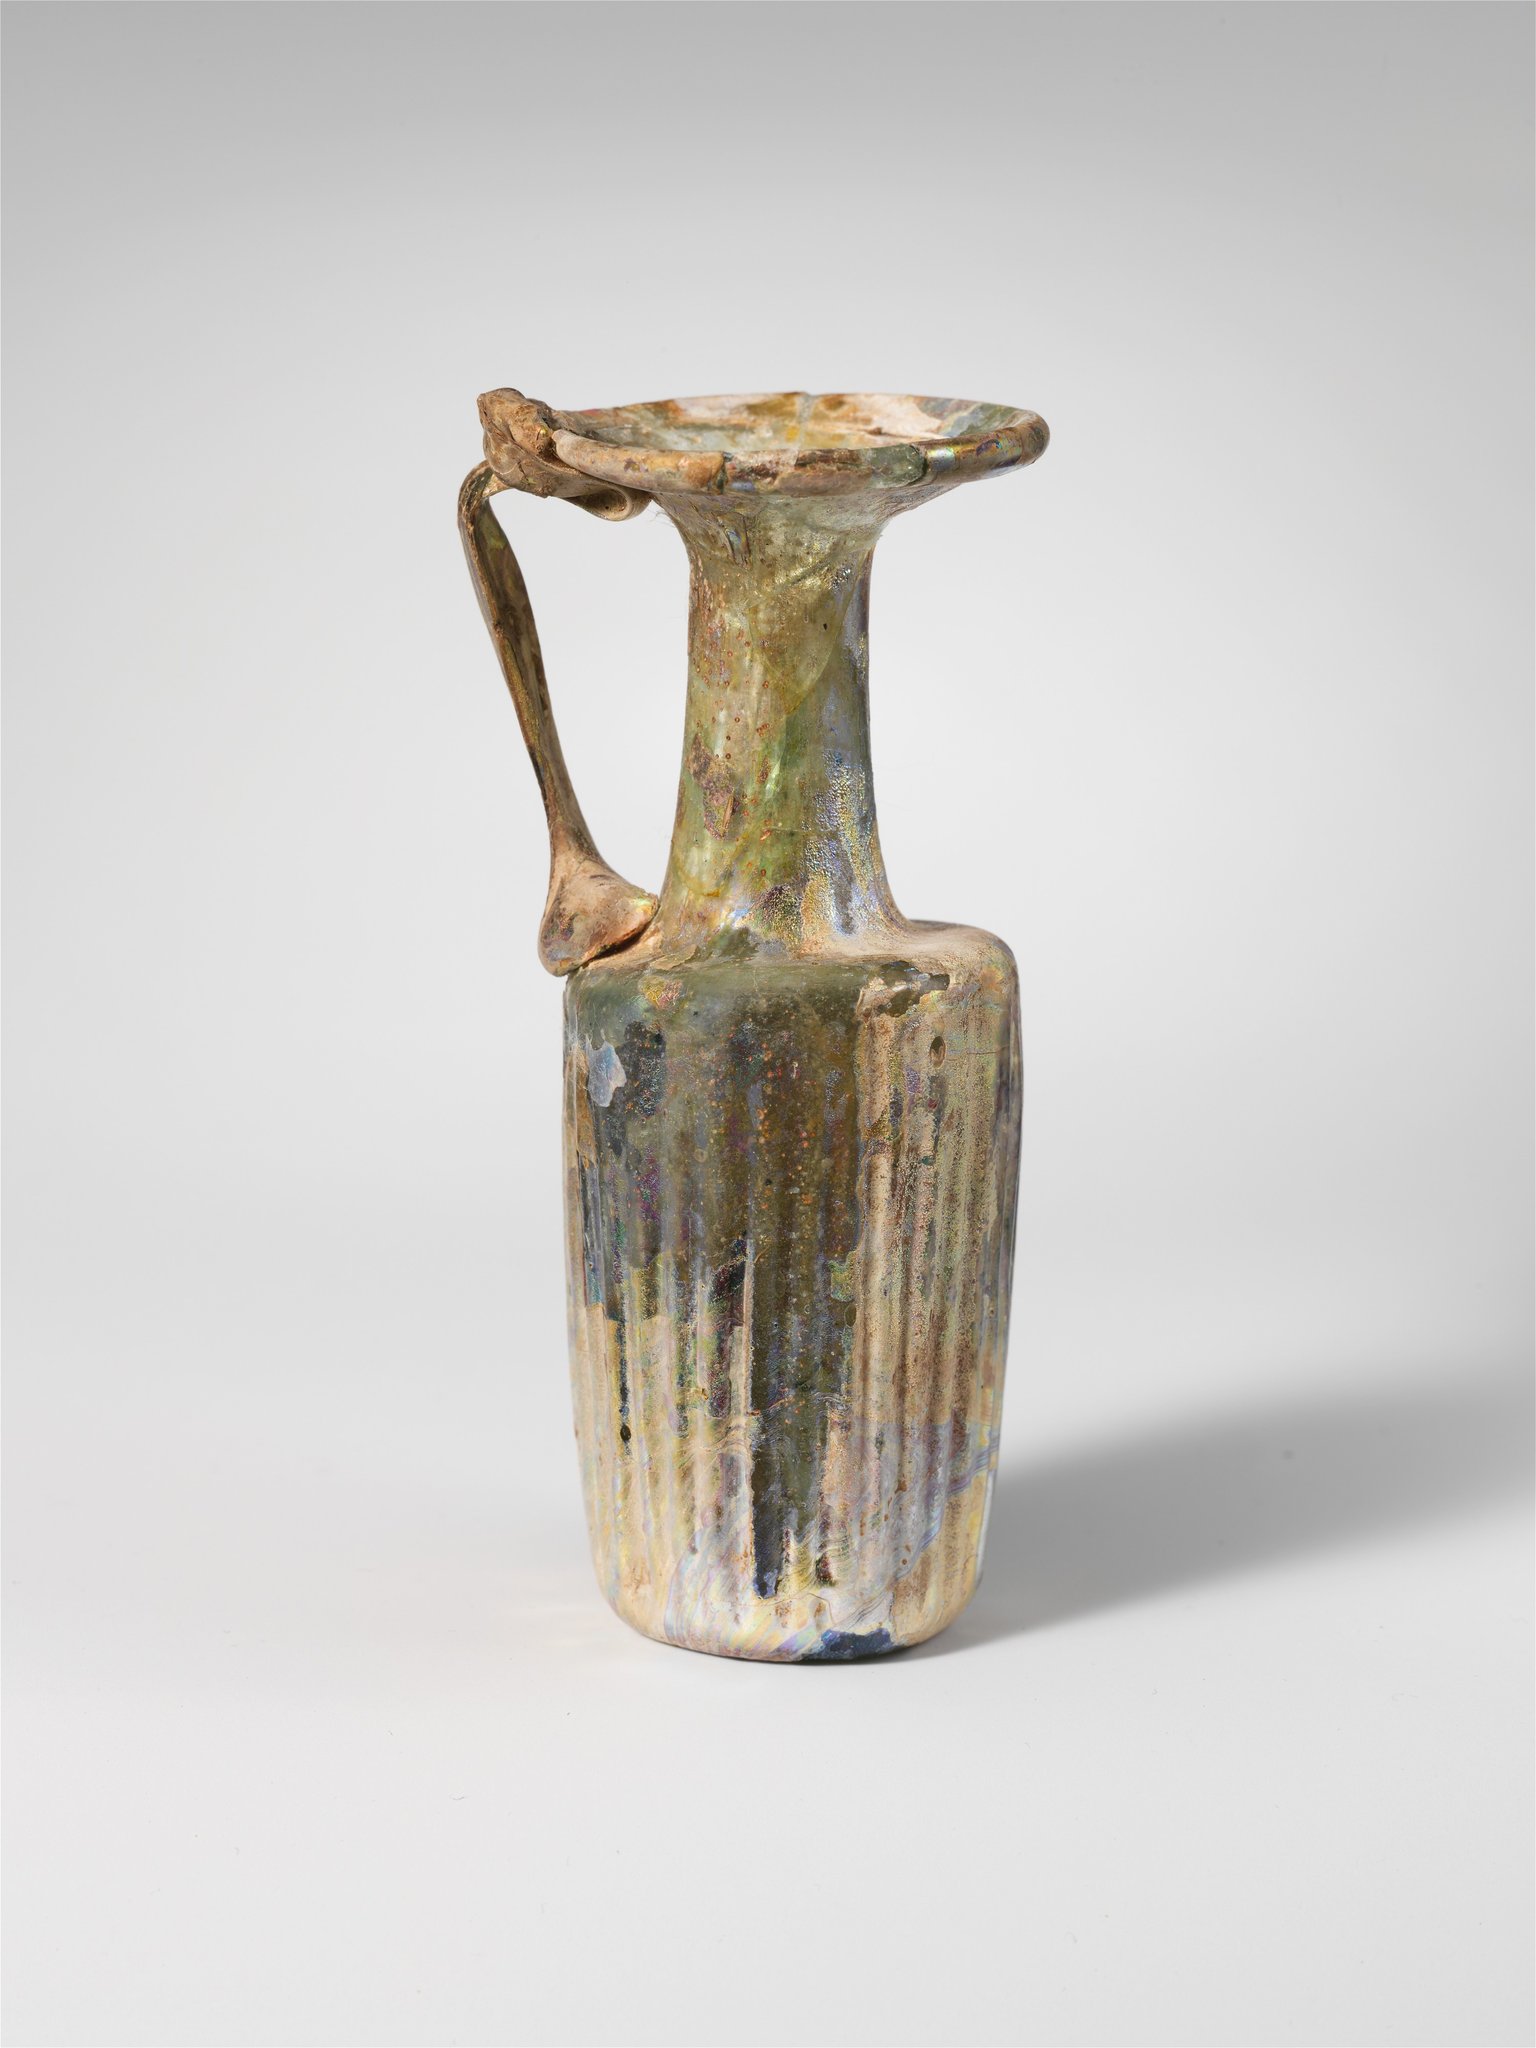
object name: jug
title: Glass jug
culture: roman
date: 301-500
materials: glass